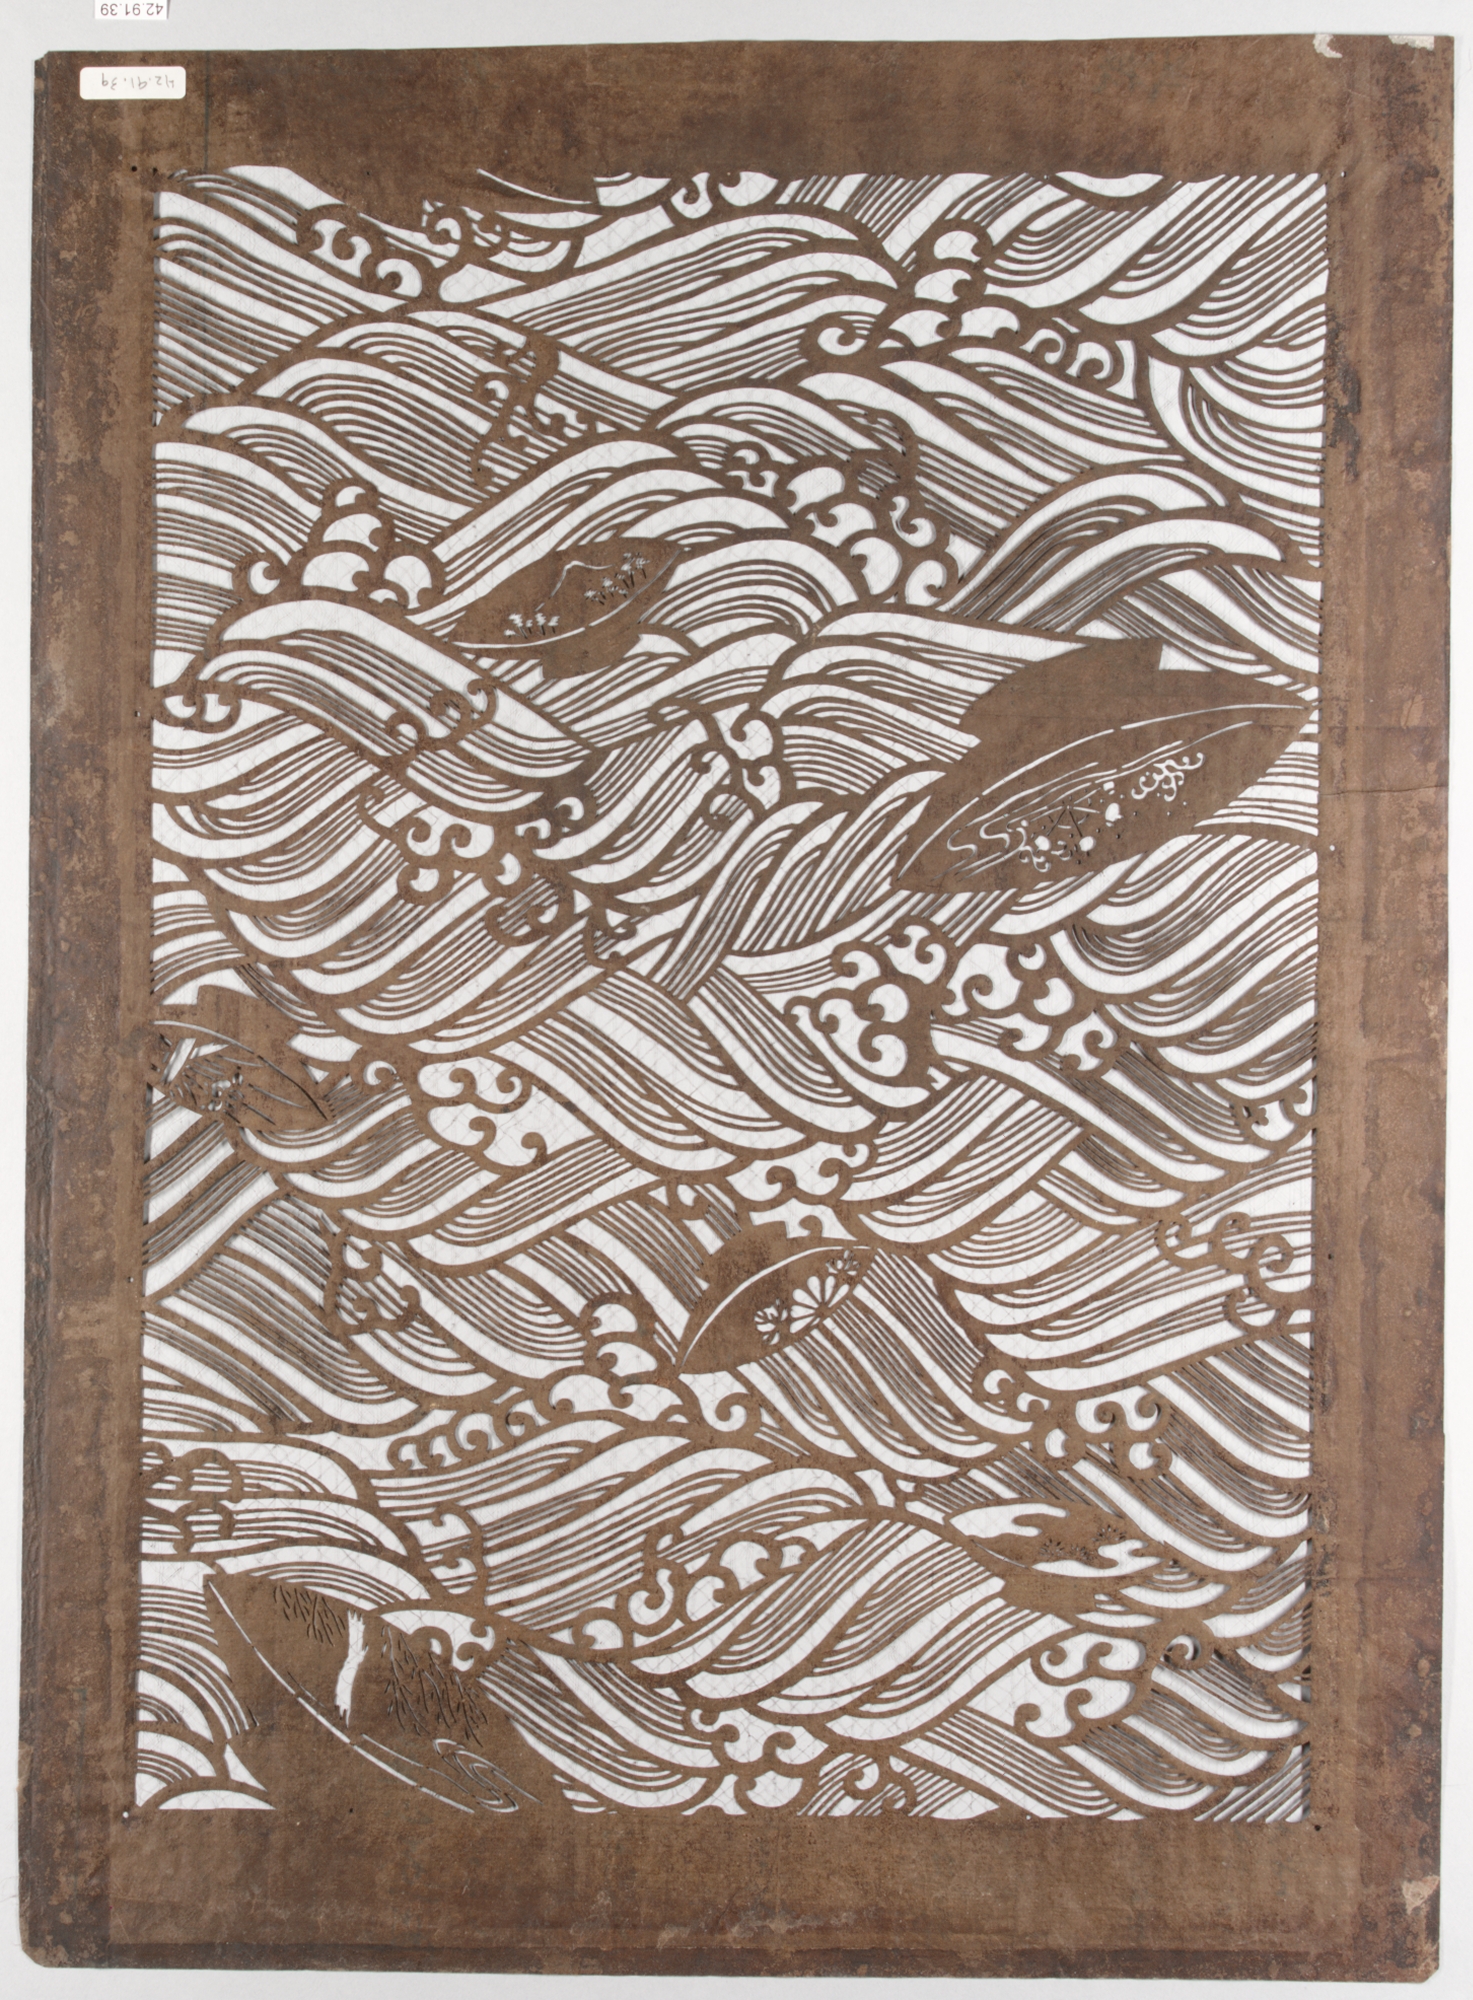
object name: stencil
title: Stencil with Pattern of Wine Cups on Waves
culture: japanese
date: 1801-1900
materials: paper, silk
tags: waves